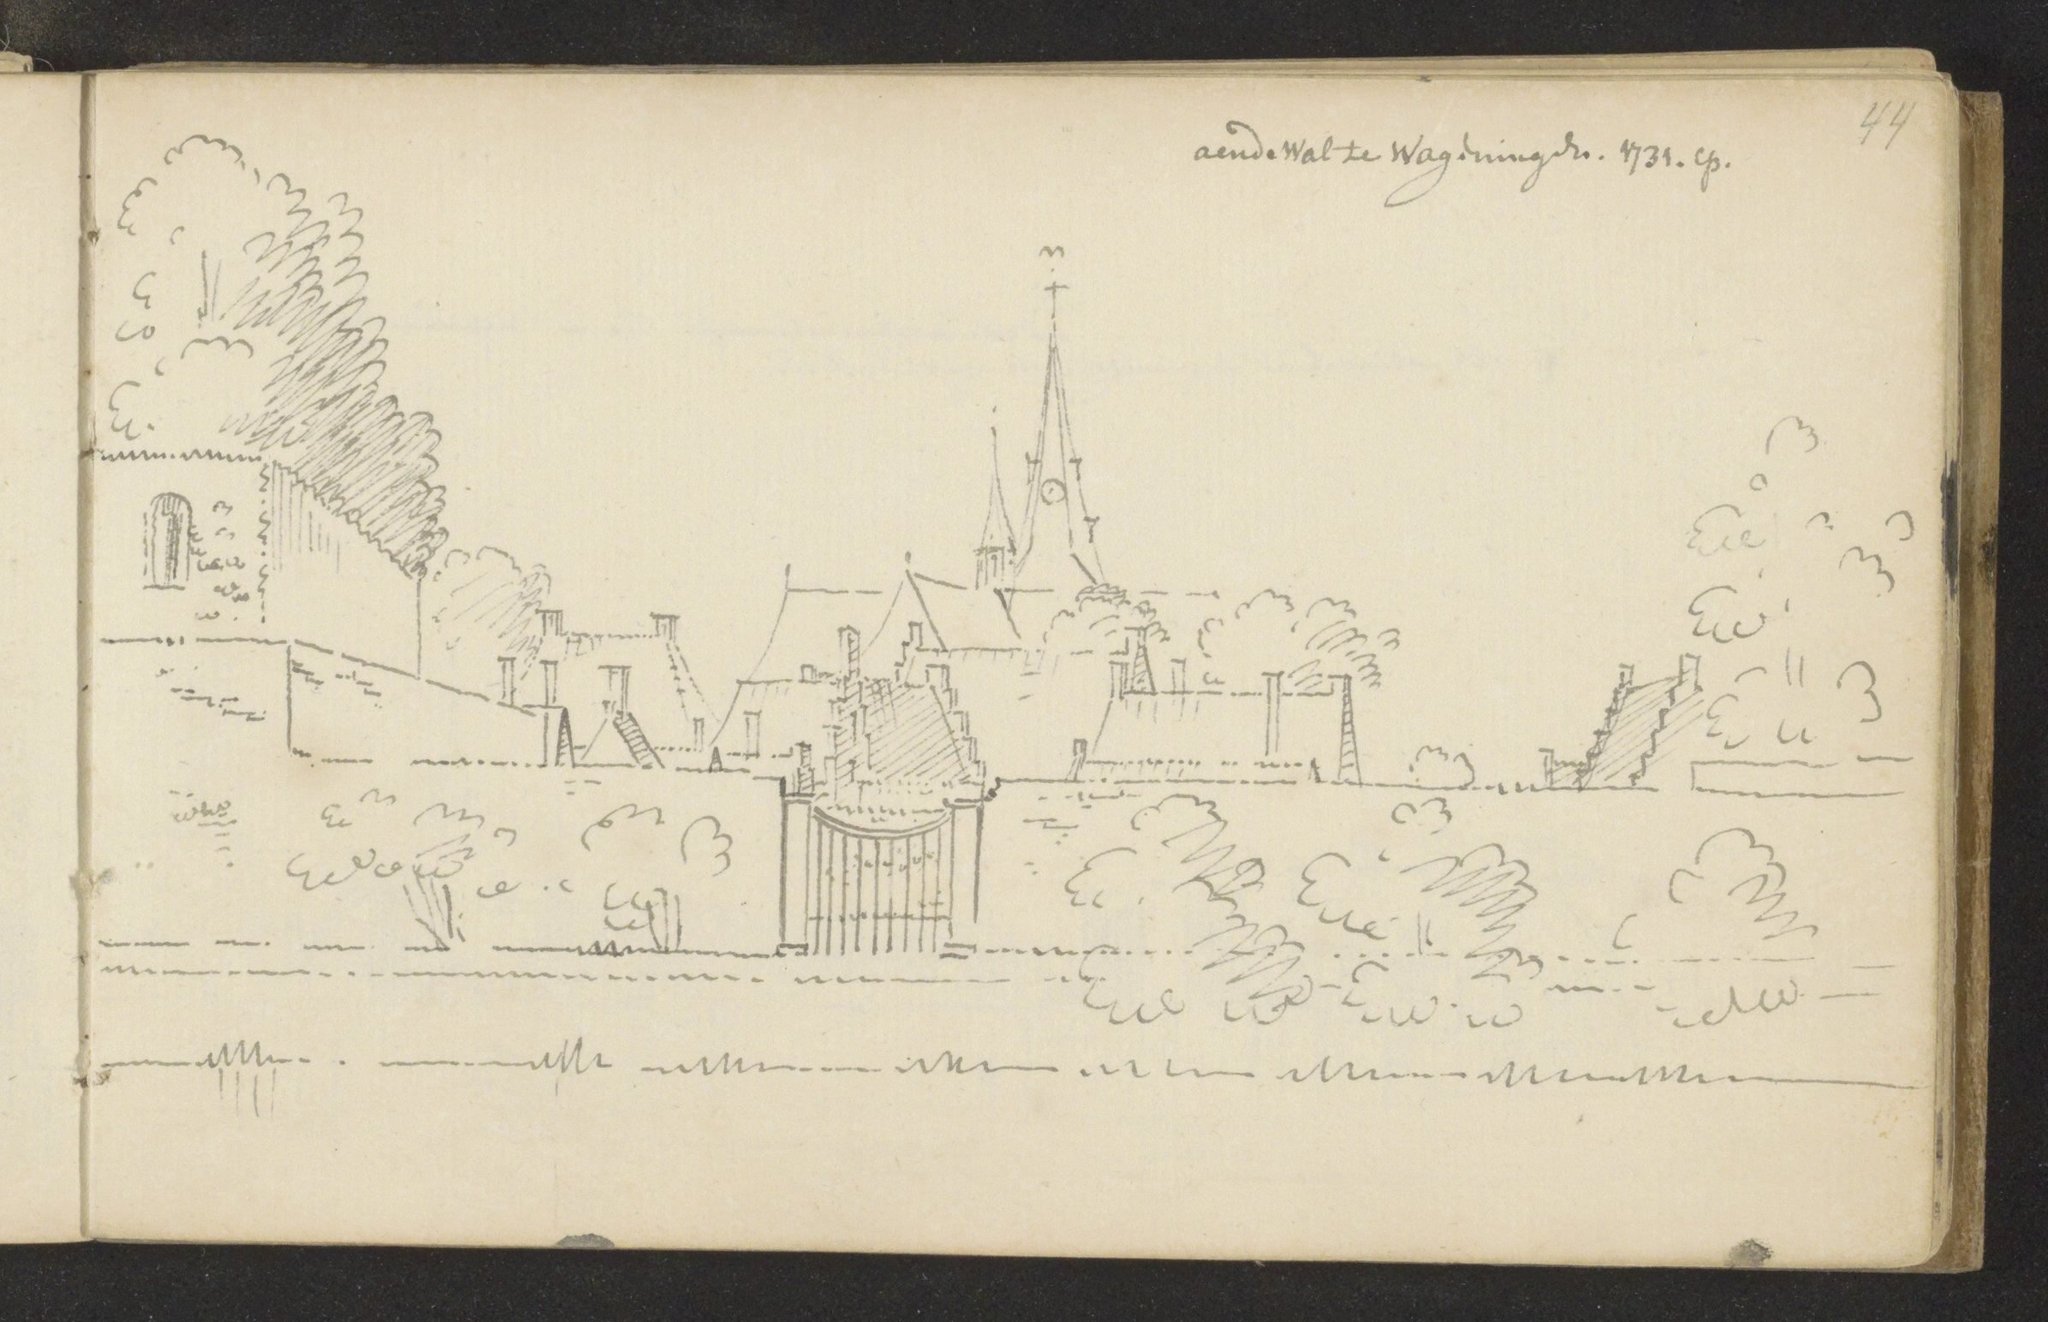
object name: sketchbook leaf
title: Gezicht op Wageningen van buiten de stadsmuur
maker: abraham de haen (ii)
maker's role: draughtsman, print maker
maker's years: 1707-1748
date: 1731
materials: ink, paper, pencil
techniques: pen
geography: wageningen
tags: city-walls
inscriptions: date and inscription: ‘aan de Wal te Wageningen.1731.cp.’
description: Blad 44 recto uit een schetsboek met 78 bladen.